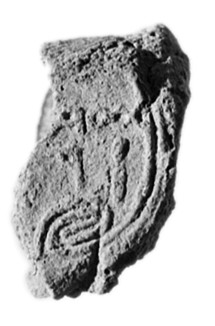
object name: sealing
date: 1981-1640 BCE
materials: mud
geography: egypt